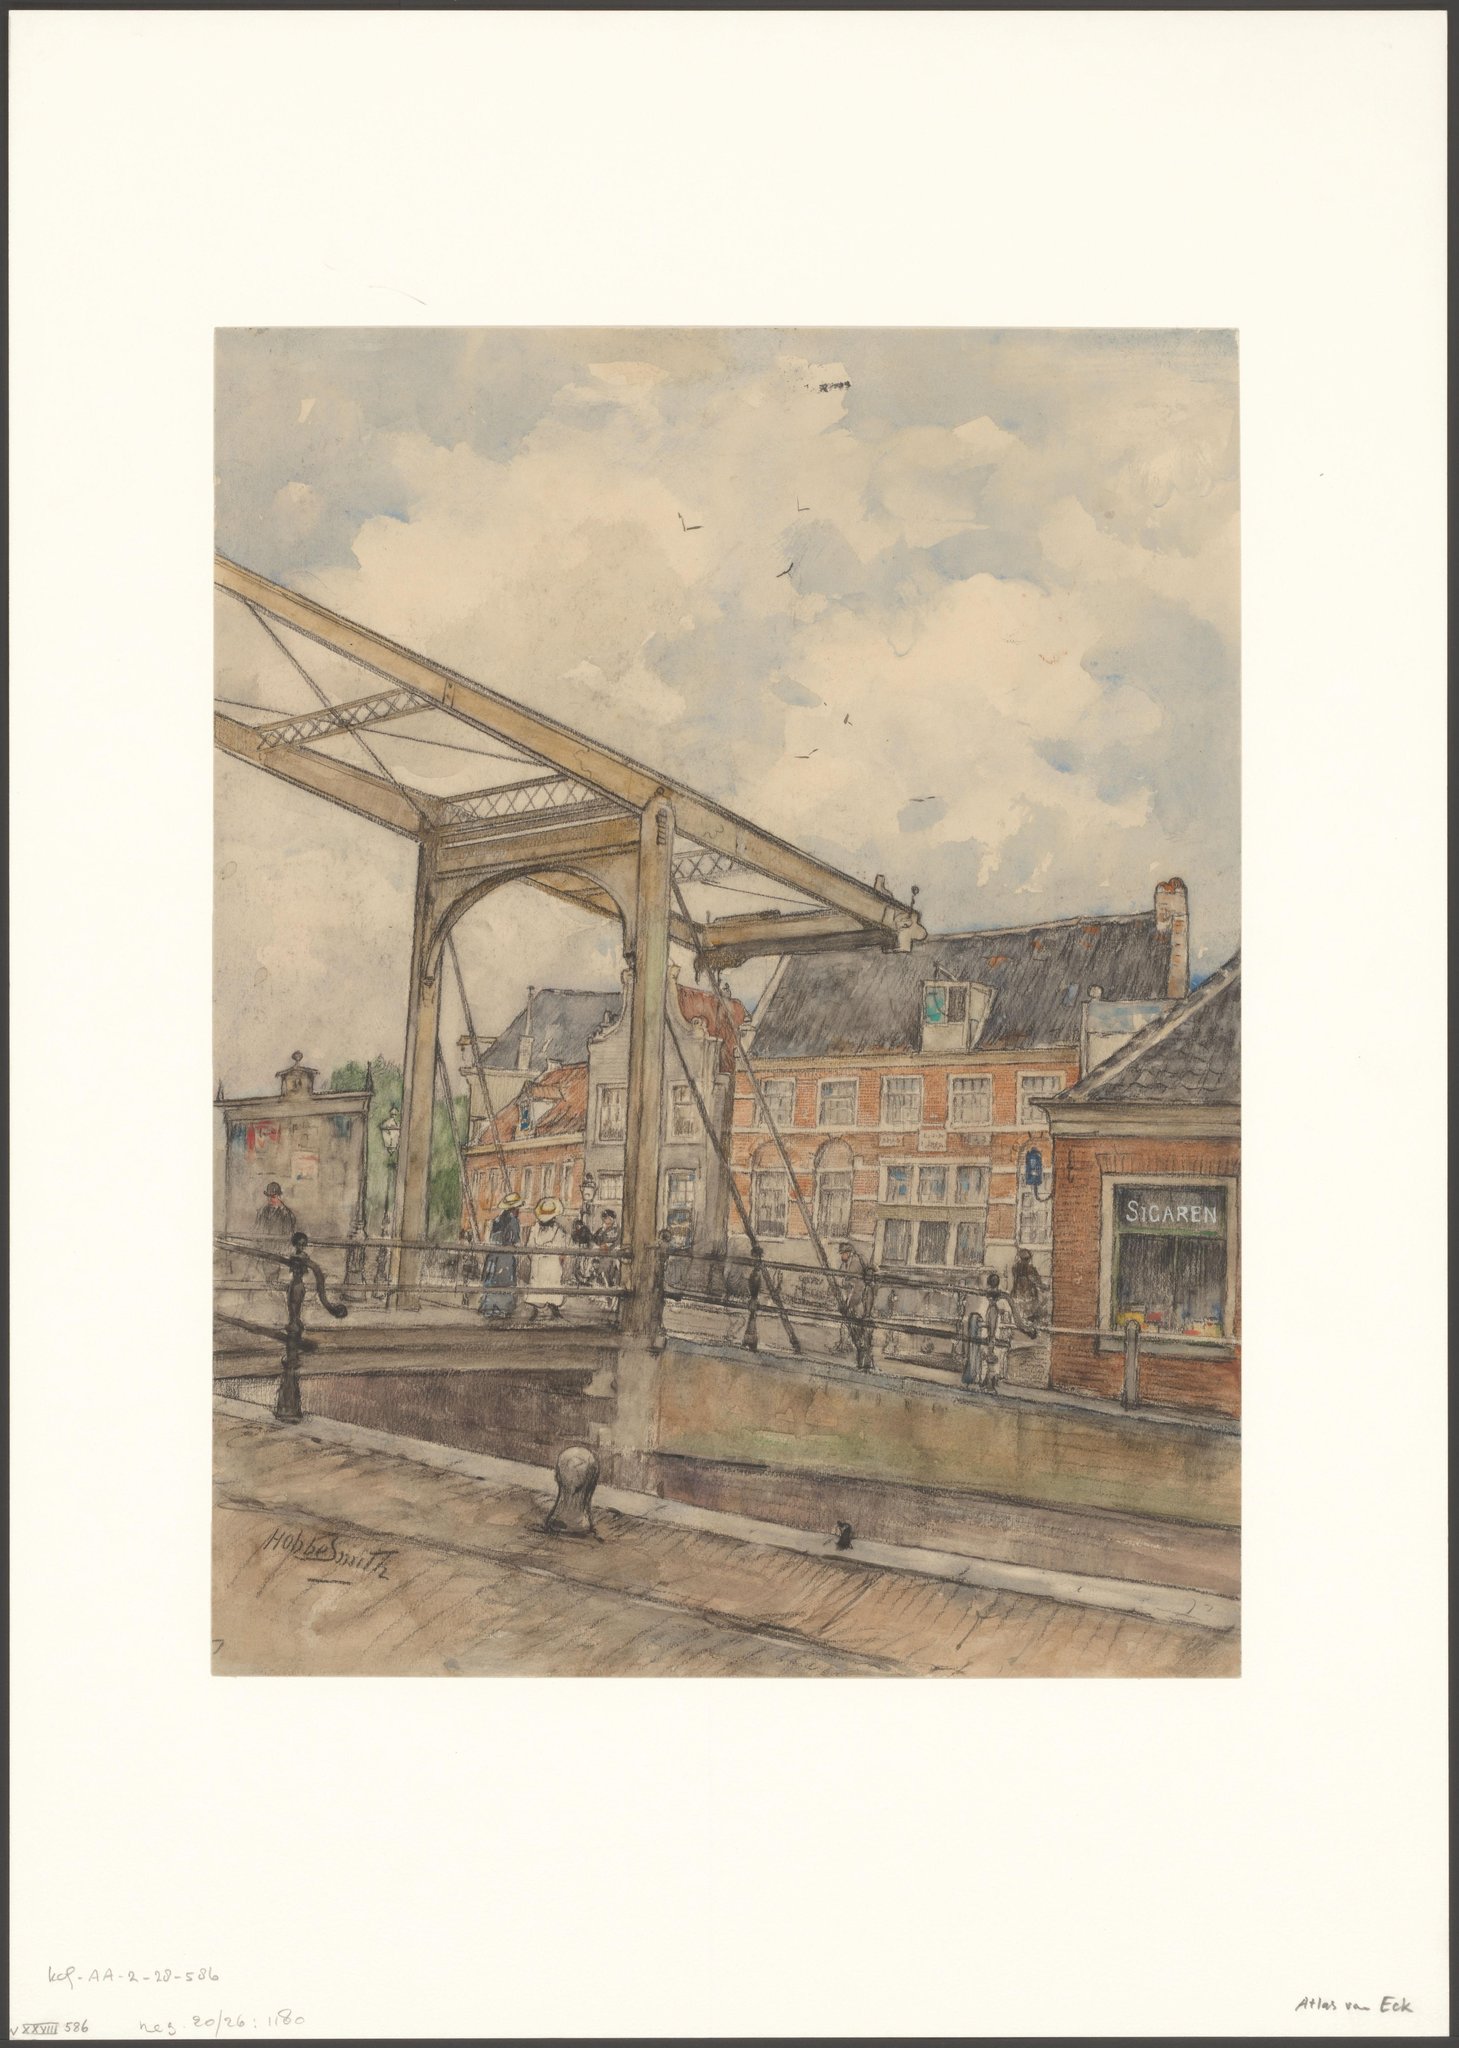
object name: drawing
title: Gezicht op de Sloterkade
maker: hobbe smith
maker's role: painter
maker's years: 1862-1942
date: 1872-1942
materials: chalk, paint, paper, watercolor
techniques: brush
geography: amsterdam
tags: city-view in general; 'veduta', canal, bridge in city across river, canal, etc.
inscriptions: signature: ‘HobbeSmith’, collector's mark: Lugt 800a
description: Tekening binnen de Atlas Van Eck ingedeeld op wijknummer 28.